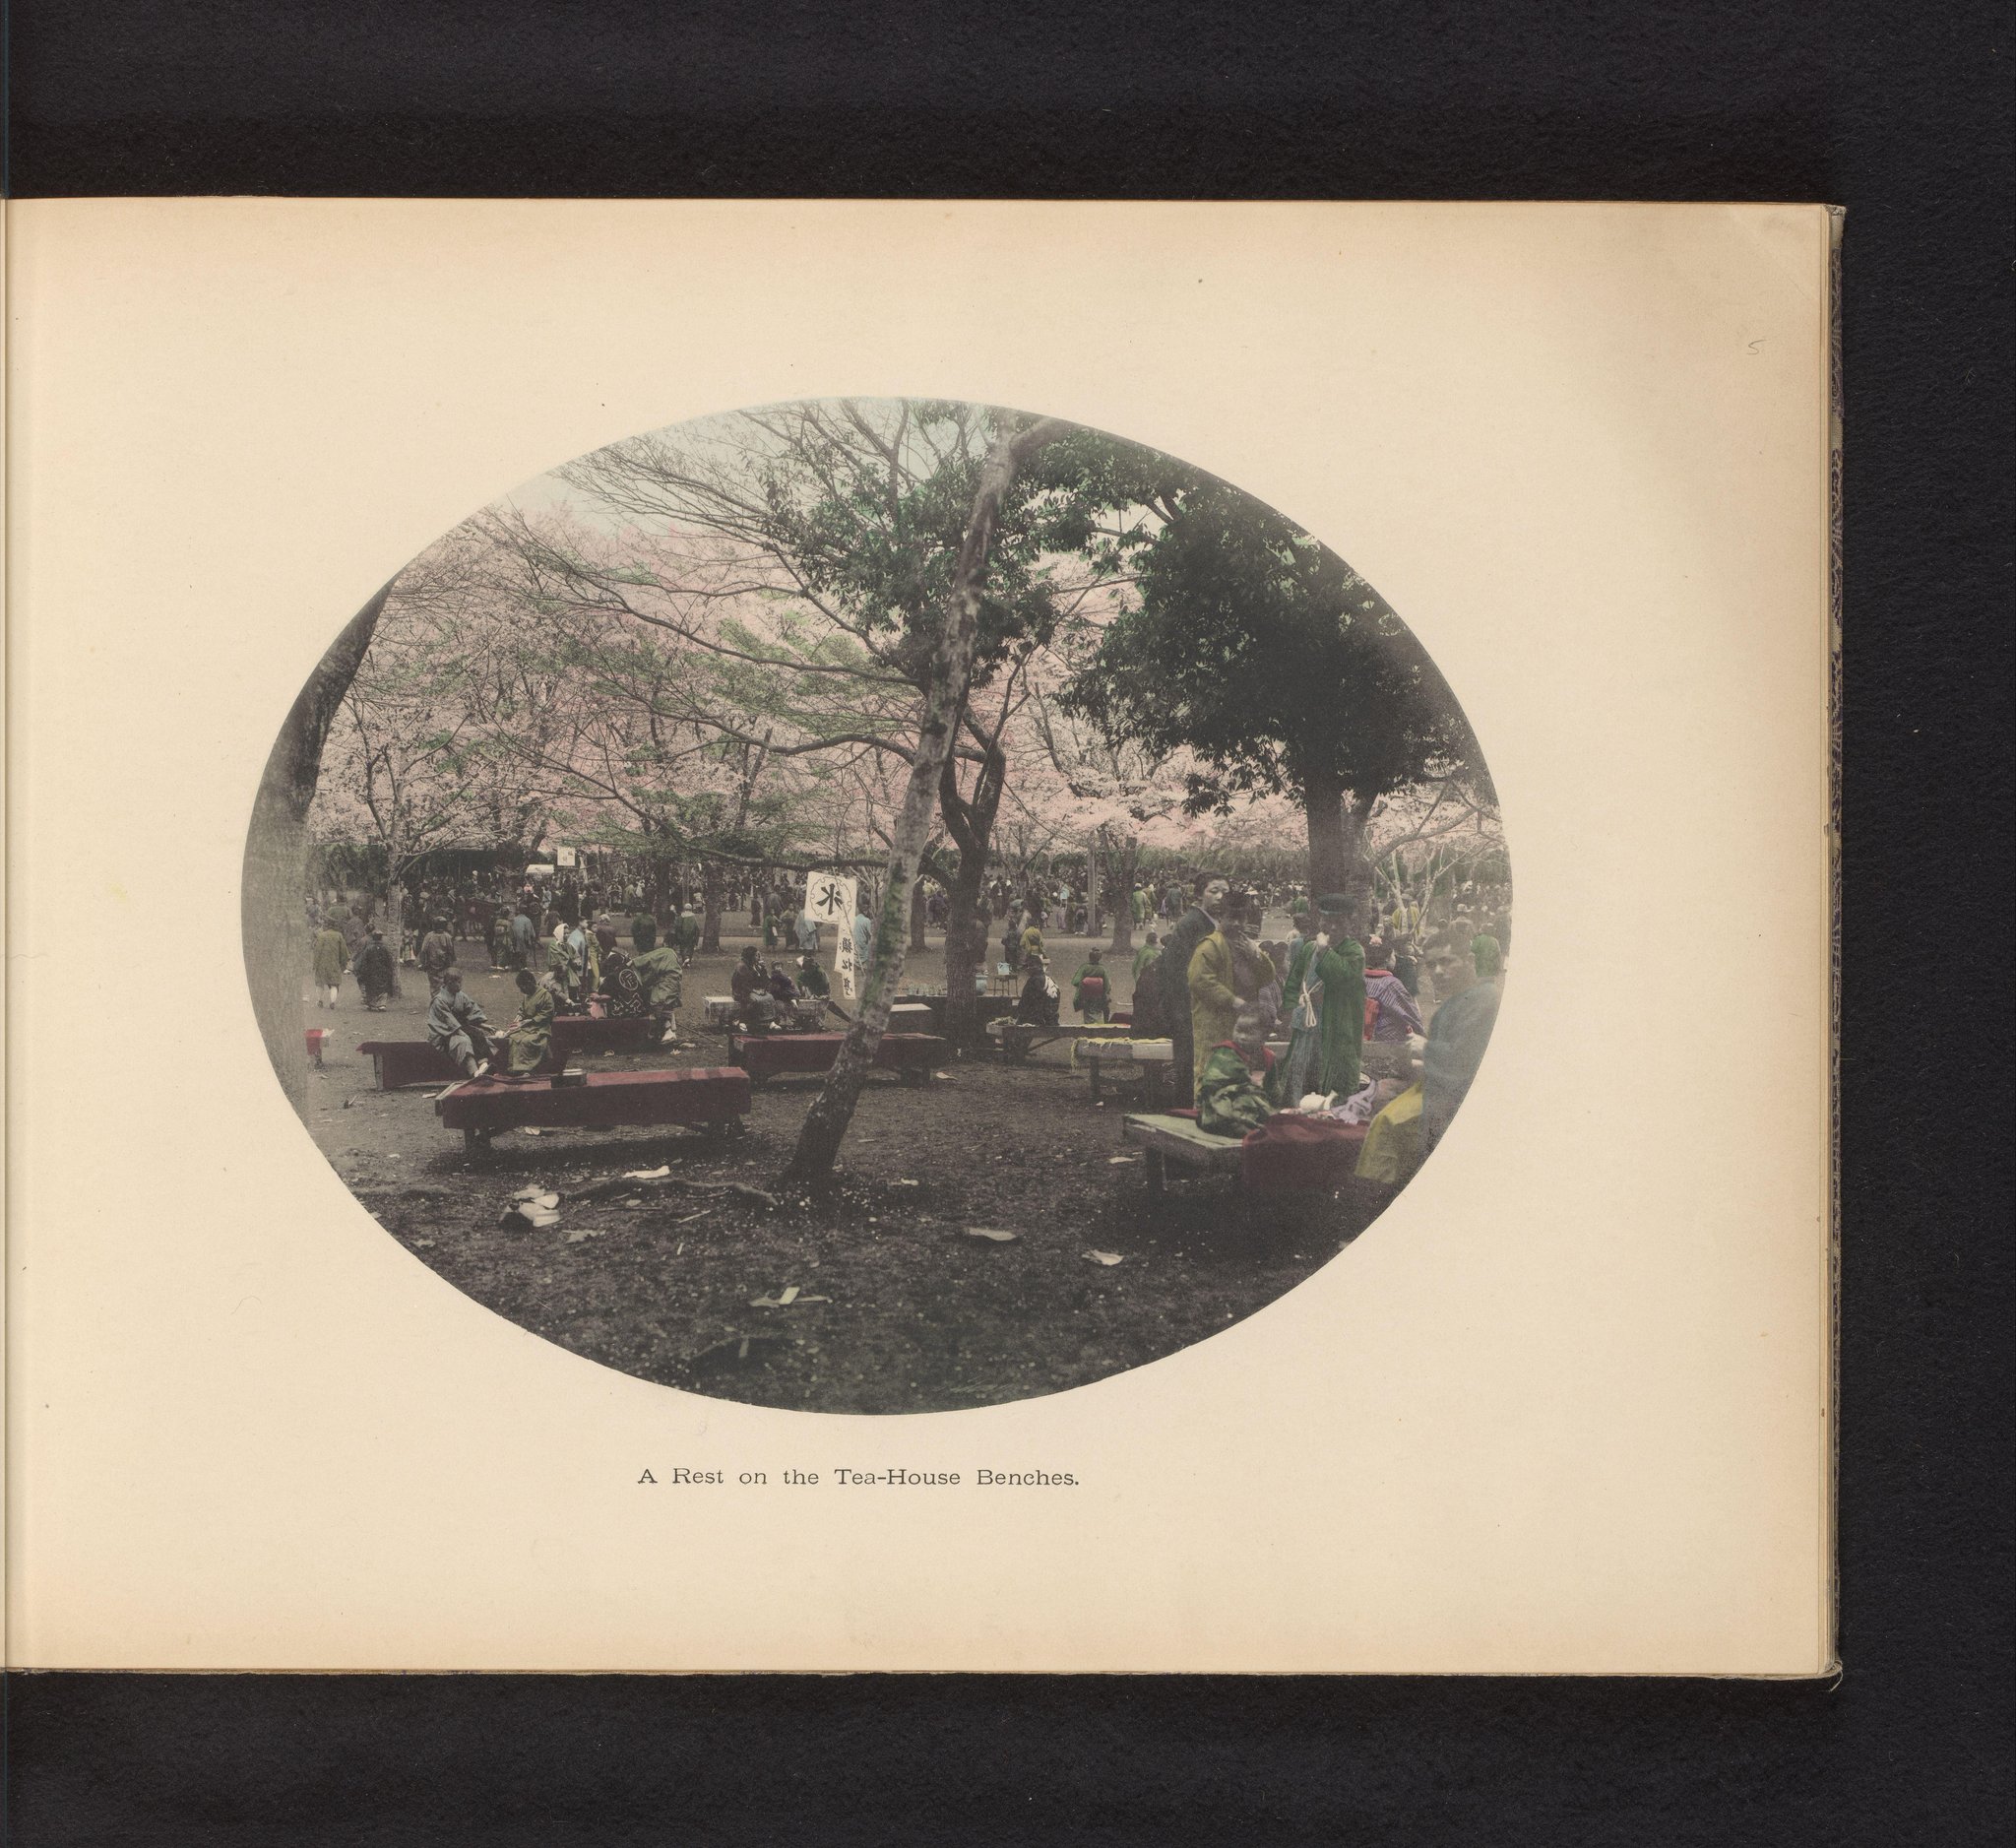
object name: photomechanical print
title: Groep mensen op de bankjes van een theehuis in Uenopark in Tokyo, Japan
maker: kazumasa ogawa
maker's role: auteur, fotograaf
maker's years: 1860-1929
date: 1892-1897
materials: paper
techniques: photograph, hand coloring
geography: uenopark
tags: park, bench, adult woman (+ more than eight persons), adult man (+ more than eight persons)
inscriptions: number: ‘5’